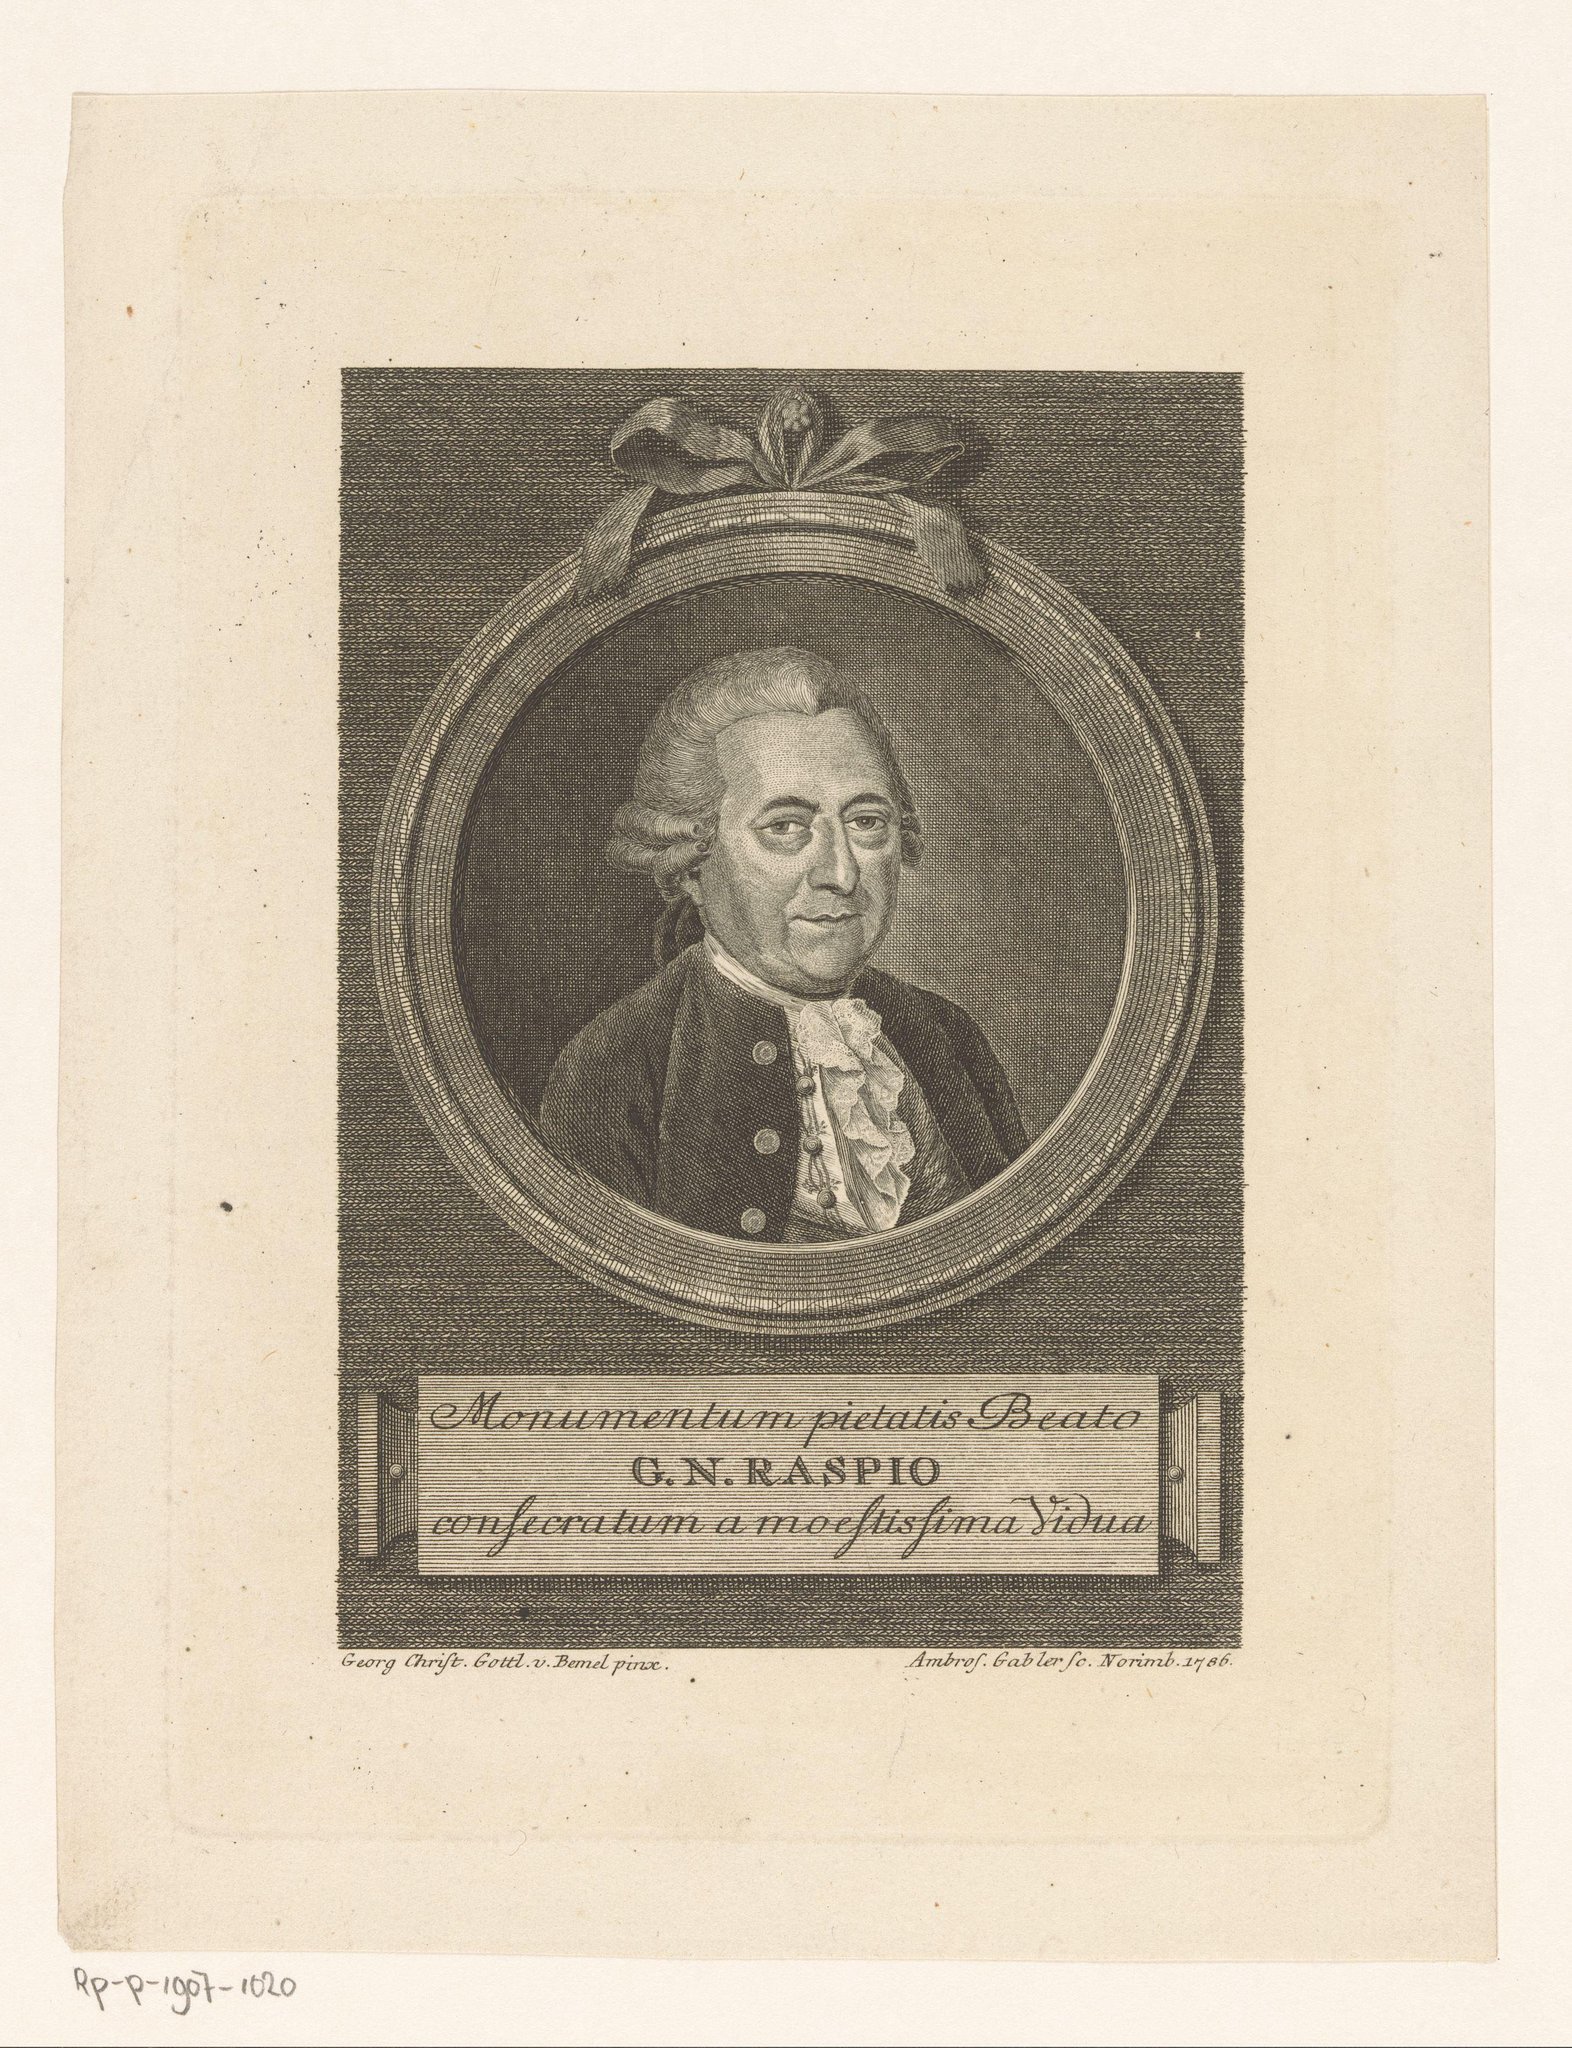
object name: print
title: Portret van Gabriel Nicolaus Raspe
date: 1786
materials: paper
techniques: engraving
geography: nuremberg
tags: gabriel nicolaus raspe, ornament ~ medallion, historical persons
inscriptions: collector's mark: Lugt 2228